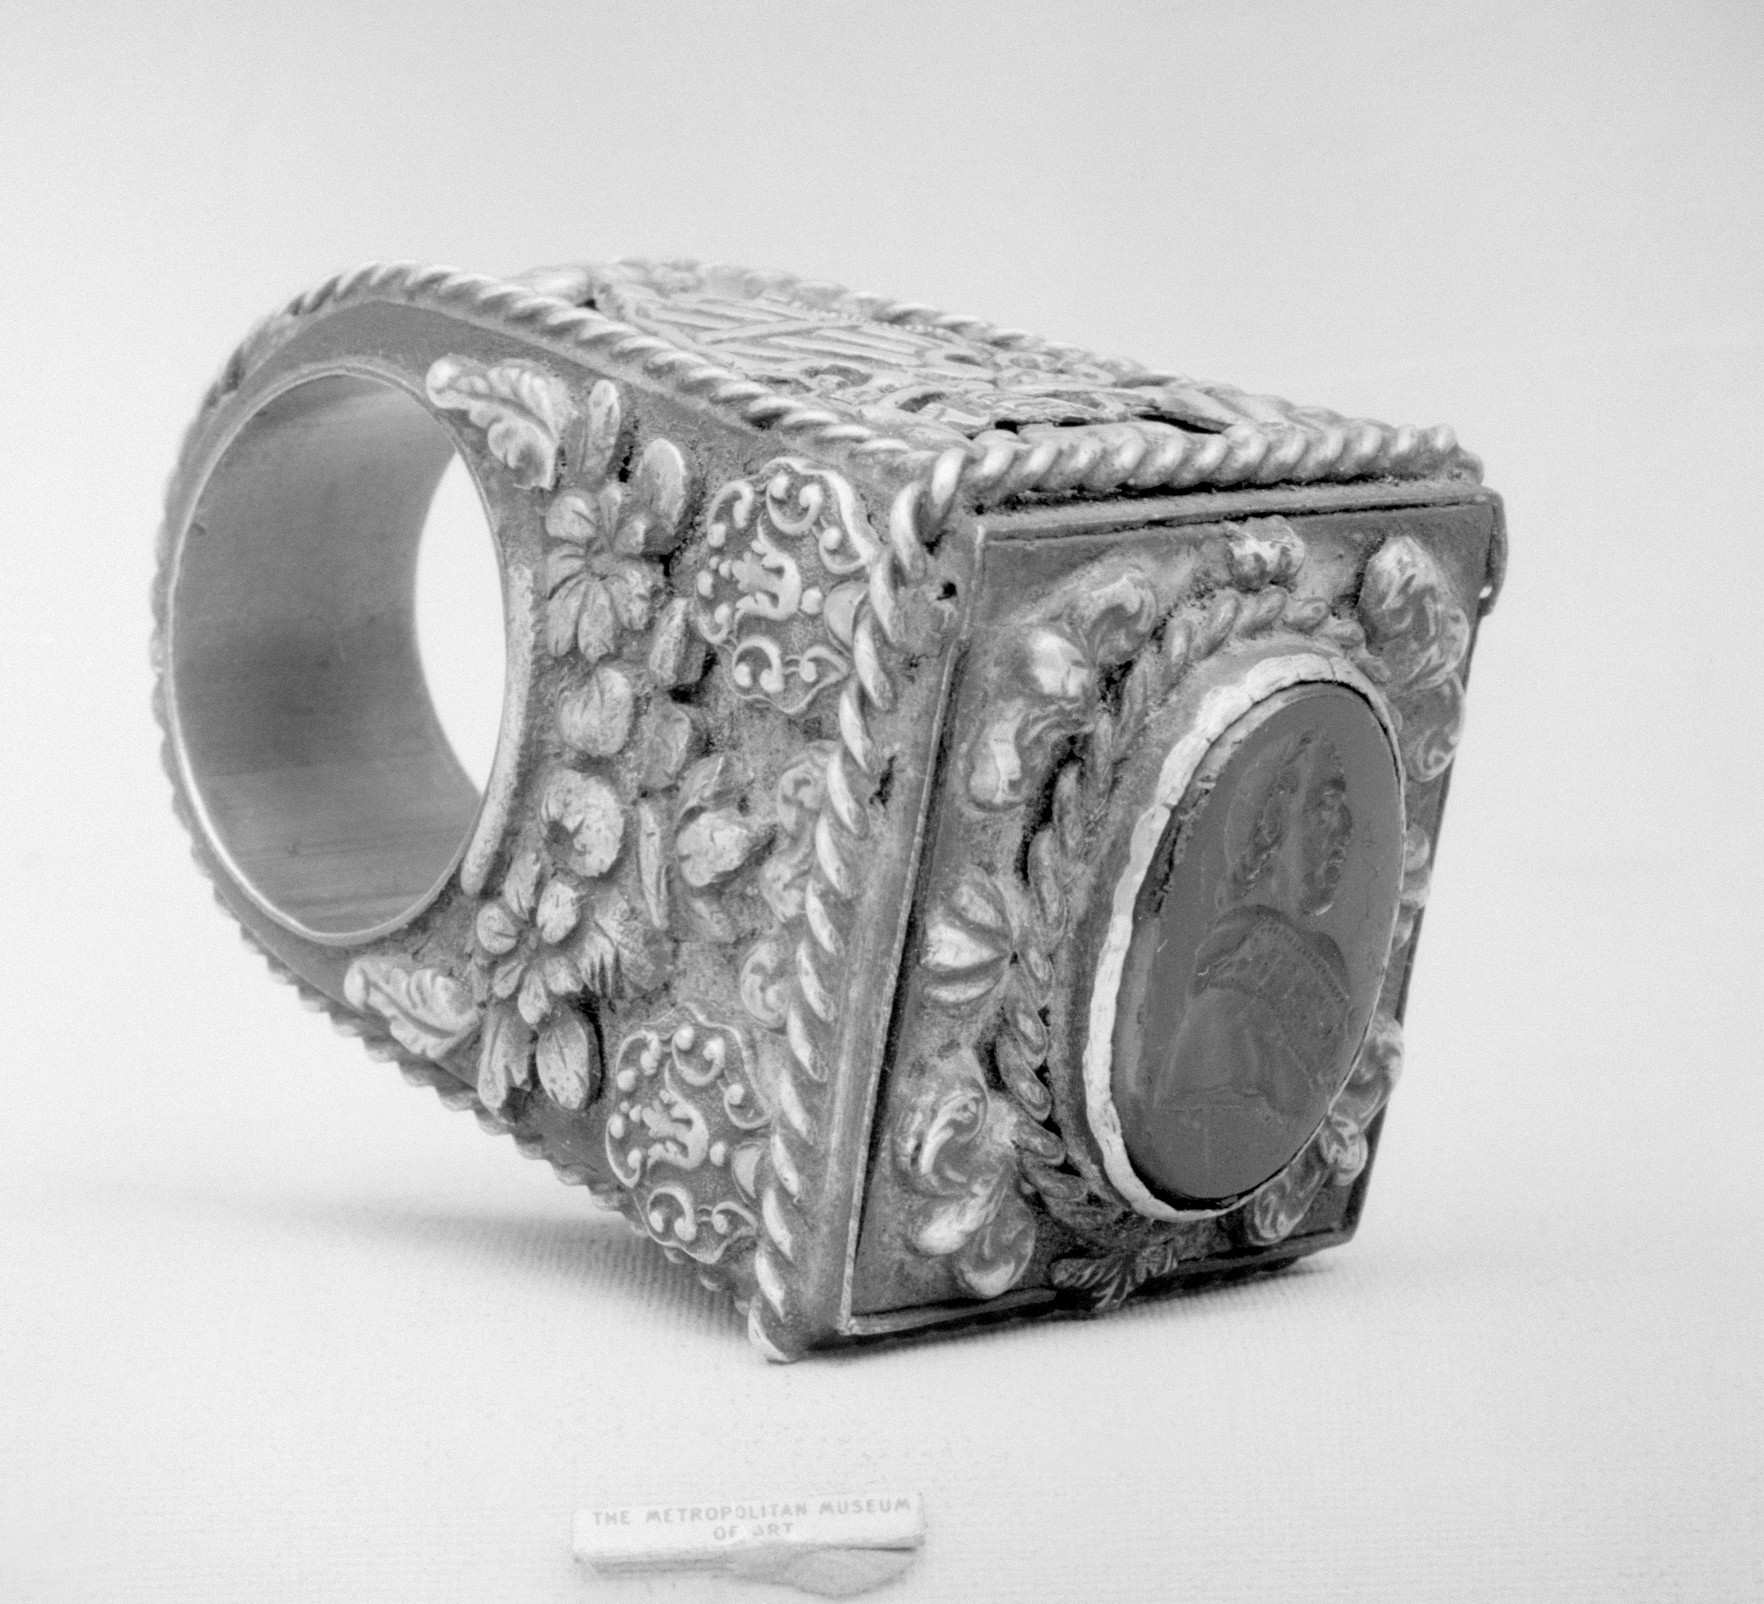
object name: seal ring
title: Ring with Pontifical seal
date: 1725-1750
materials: silver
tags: rings,profiles